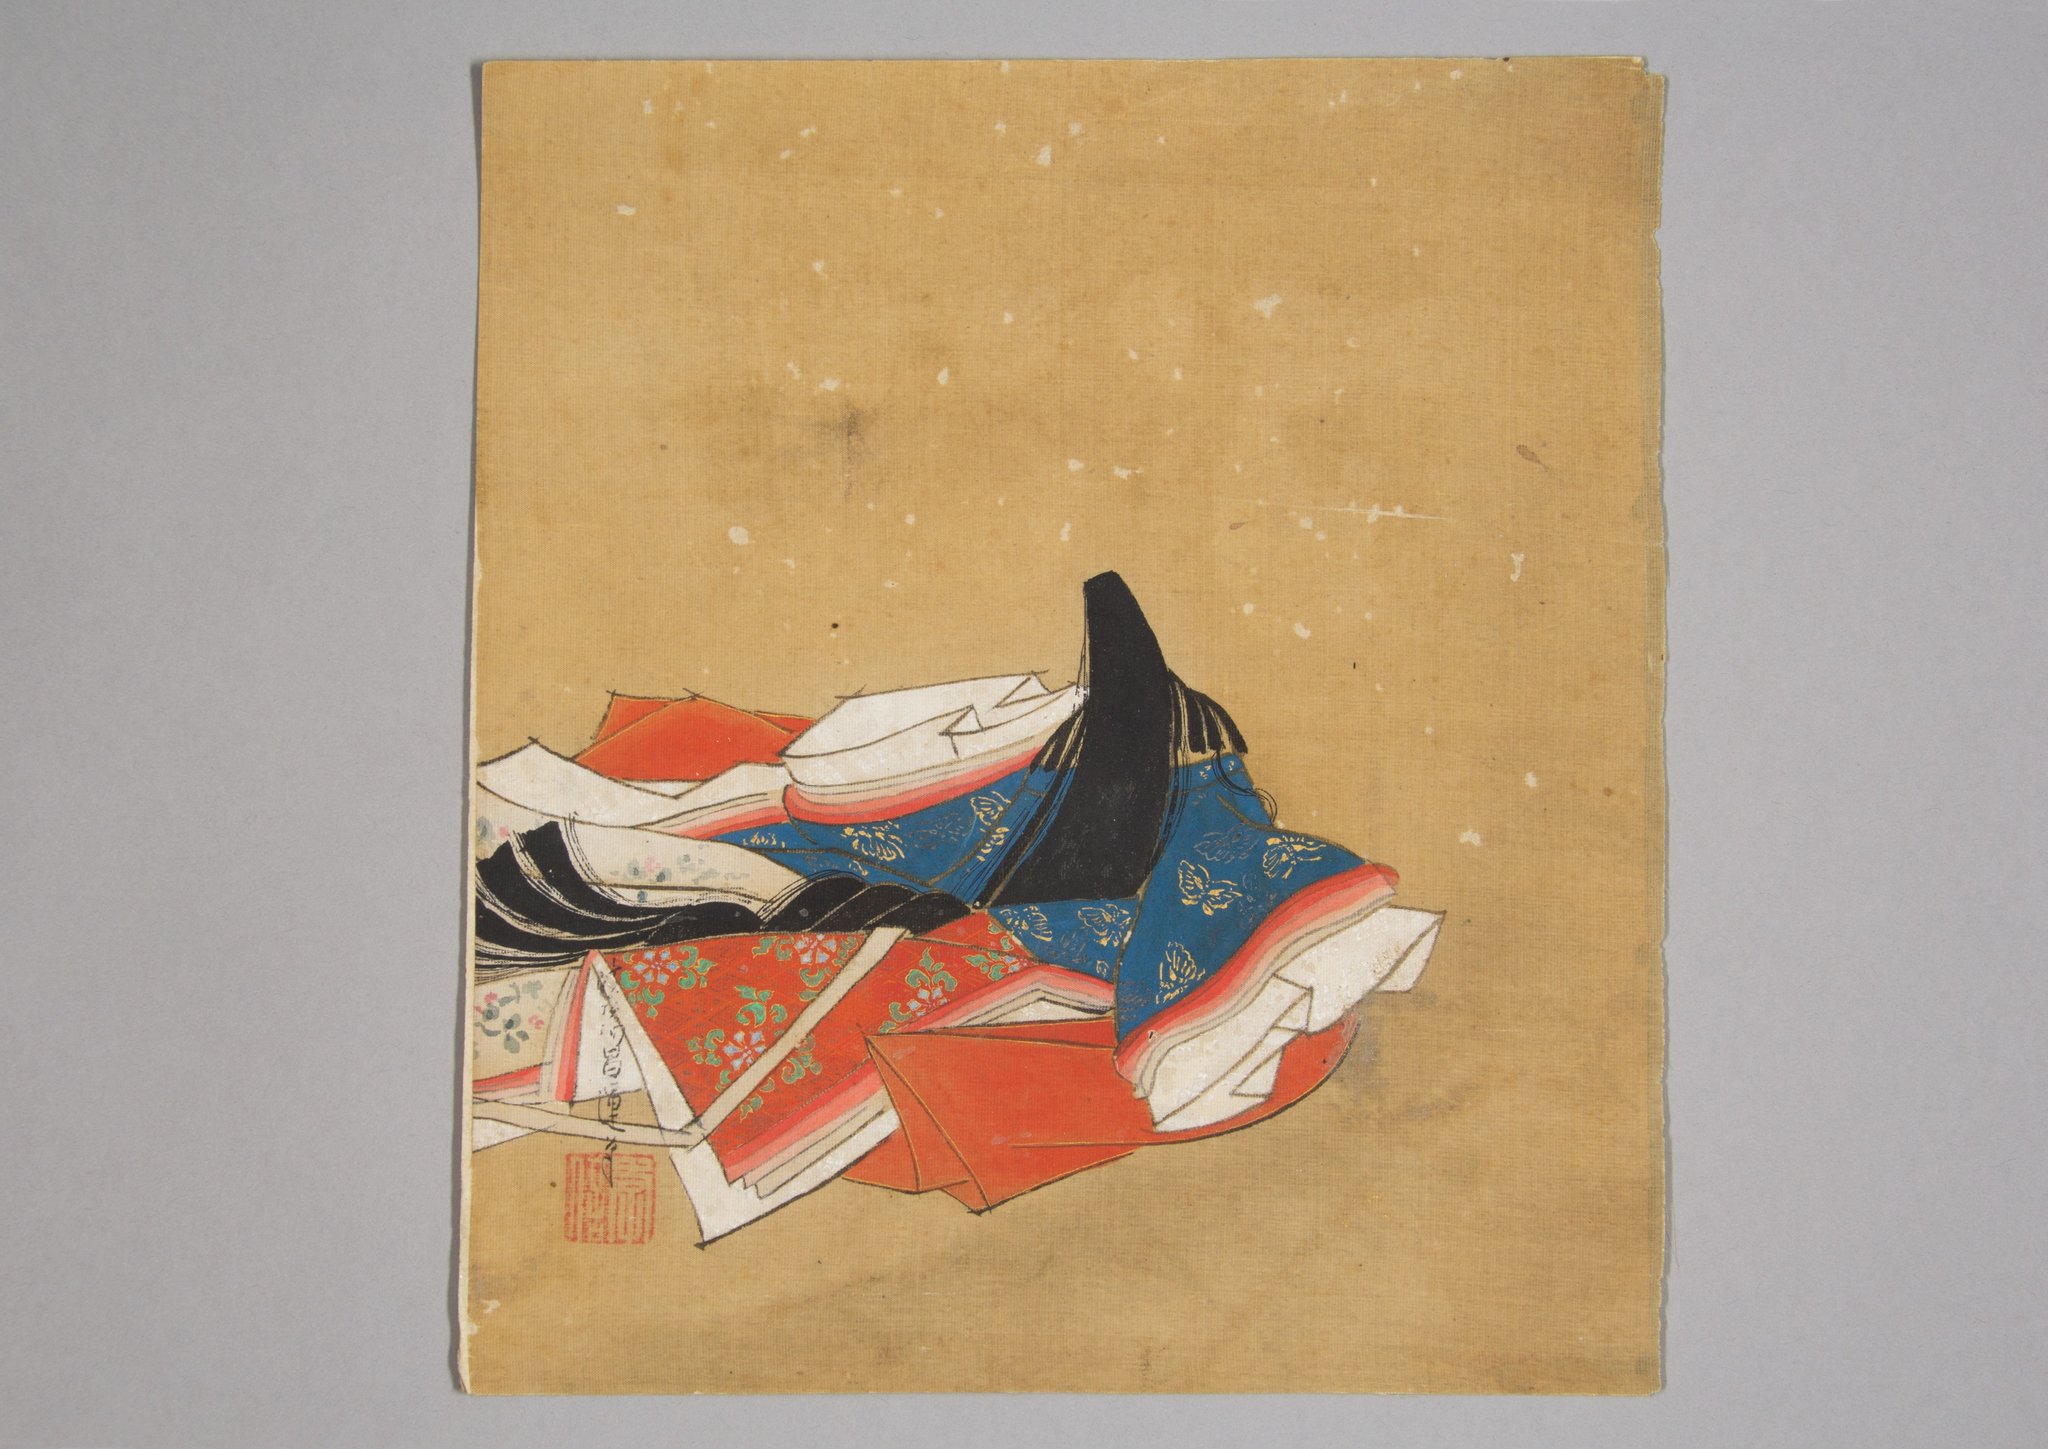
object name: painting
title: Immortal Poet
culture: japanese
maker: kano shōun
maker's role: artist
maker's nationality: japanese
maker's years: 1637-1702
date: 1601-1700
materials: ink, silk